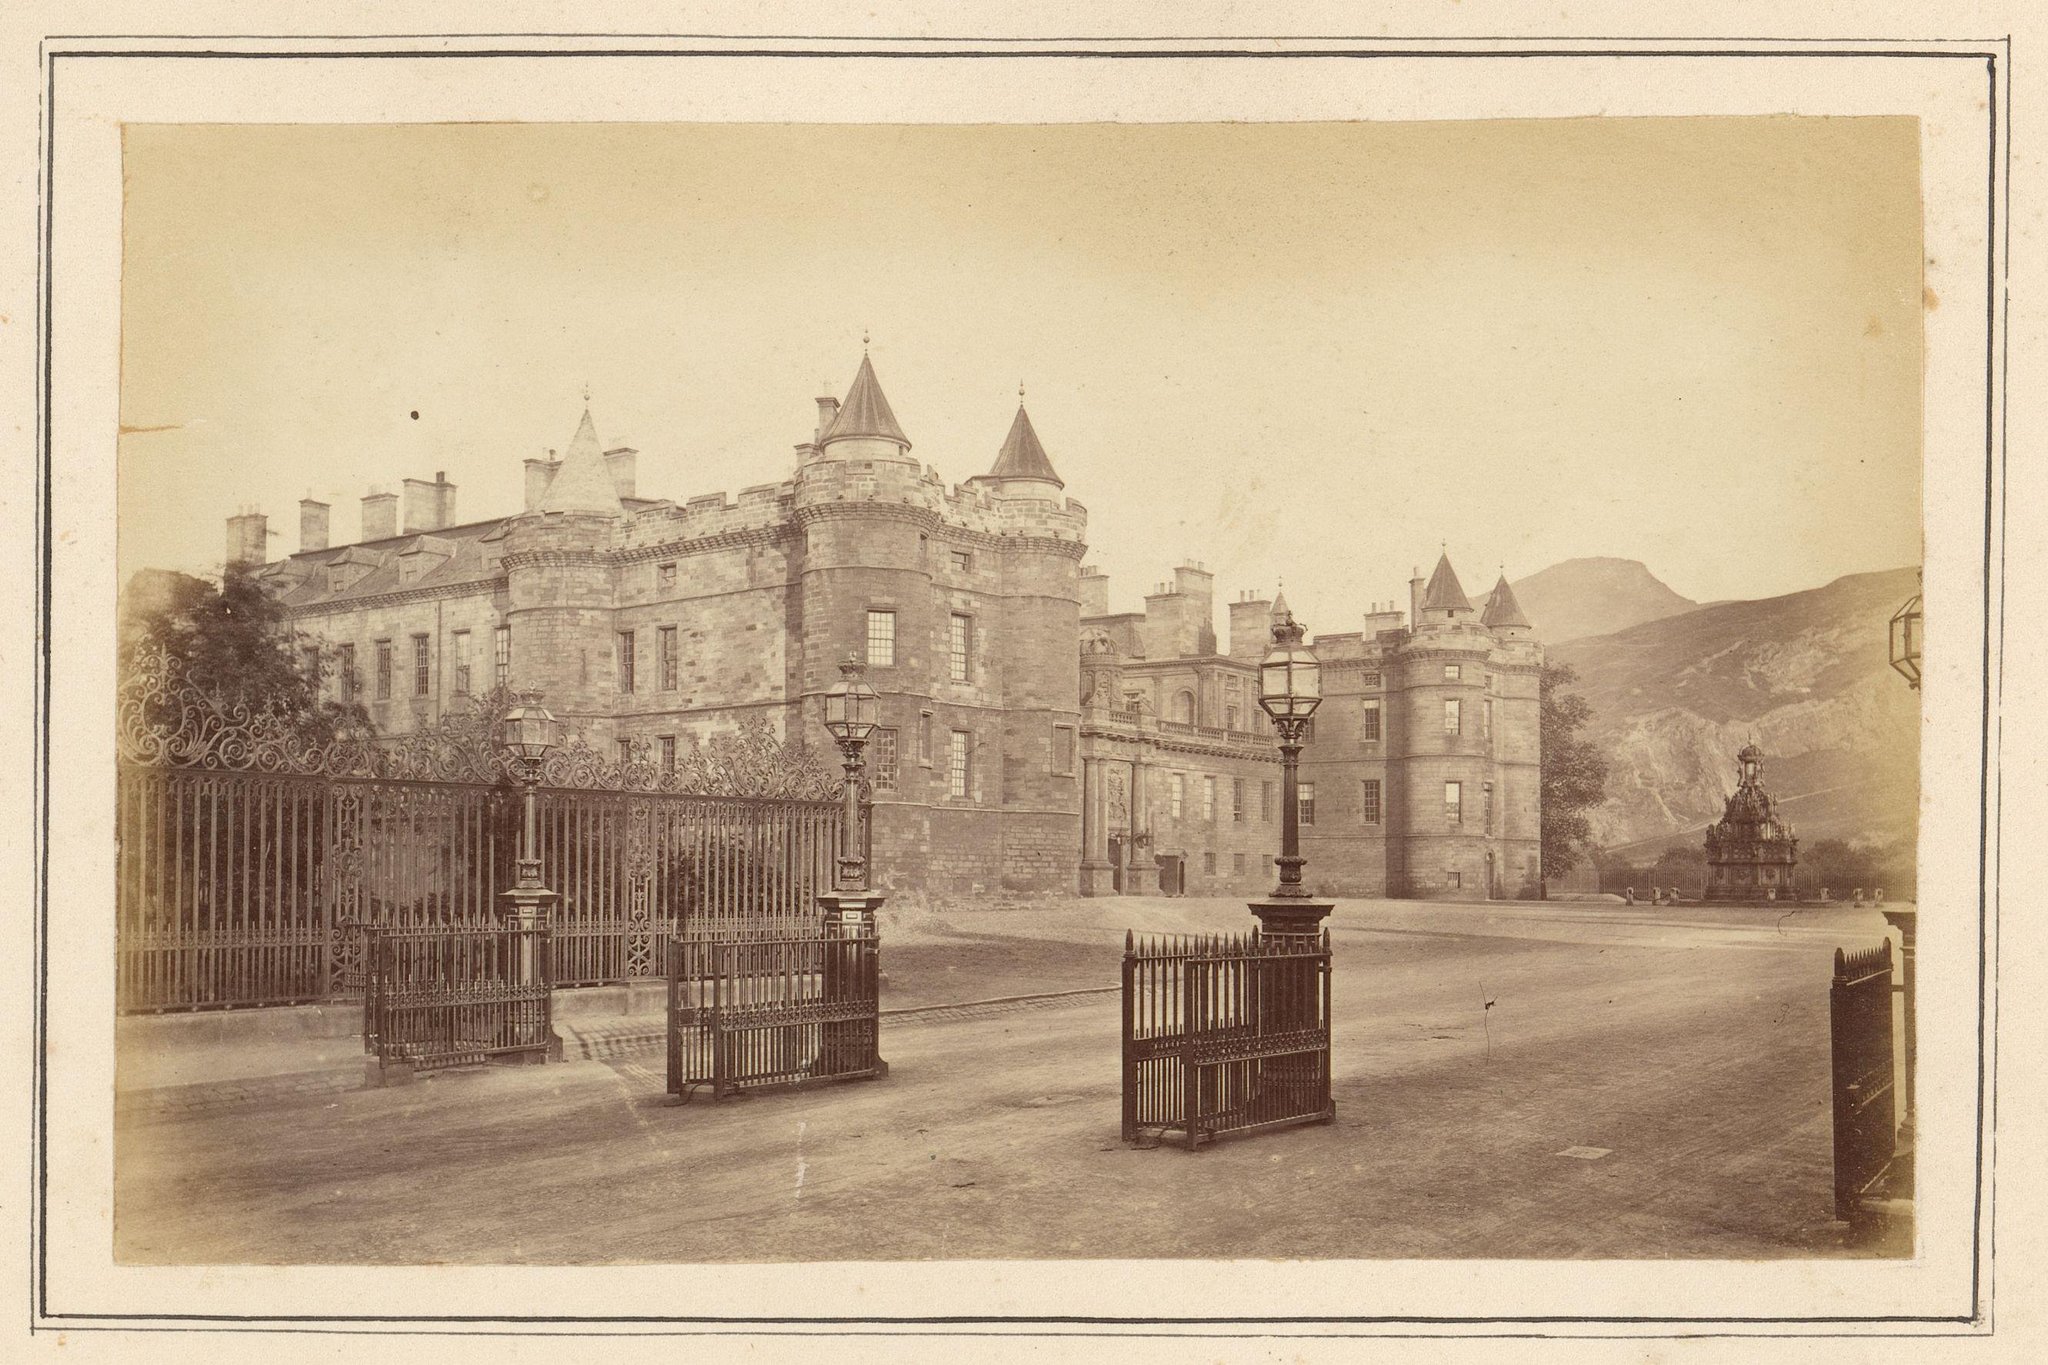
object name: album leaf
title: Holyrood-castle in Edinburg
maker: Anonymous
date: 1865-1890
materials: paper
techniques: albumen print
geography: edinburgh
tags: palace